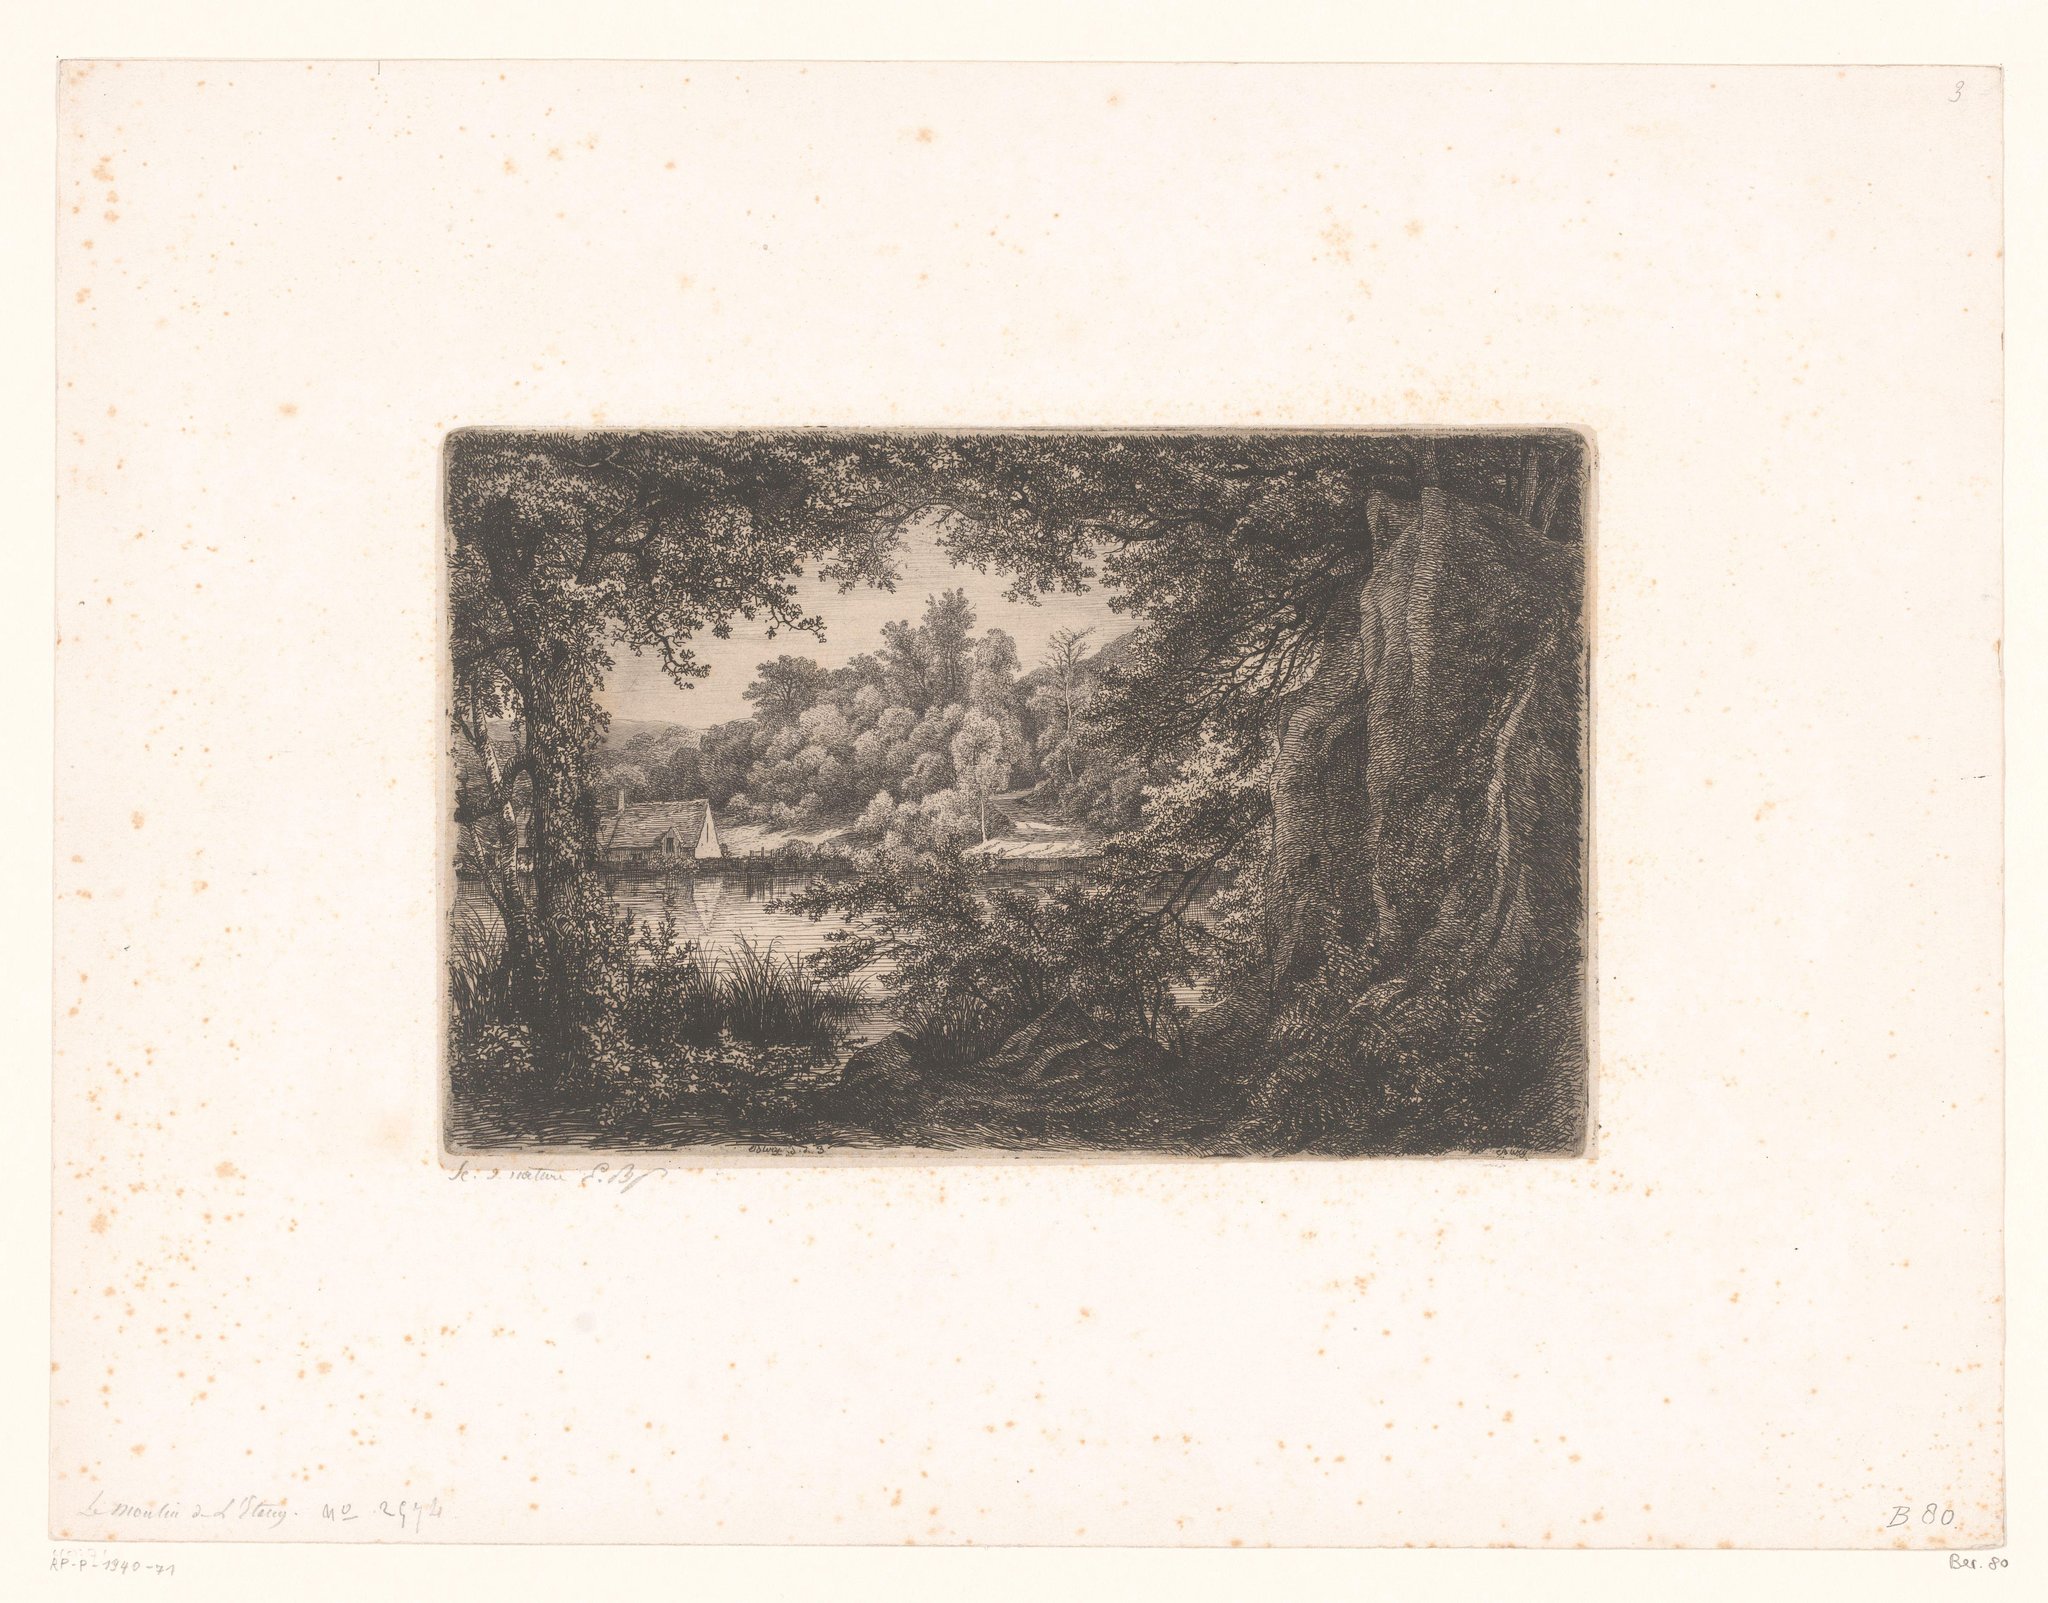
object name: print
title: Gezicht op een meer vanaf de bosrand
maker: eugène bléry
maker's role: print maker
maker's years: 1805-1887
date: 1850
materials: paper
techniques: aquatint, drypoint, etching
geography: france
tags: watermill in landscape - ii - ideal landscapes, rock-formations - hh - ideal landscapes, lake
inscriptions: collector's mark: Lugt 2760, collector's mark: Lugt 2166